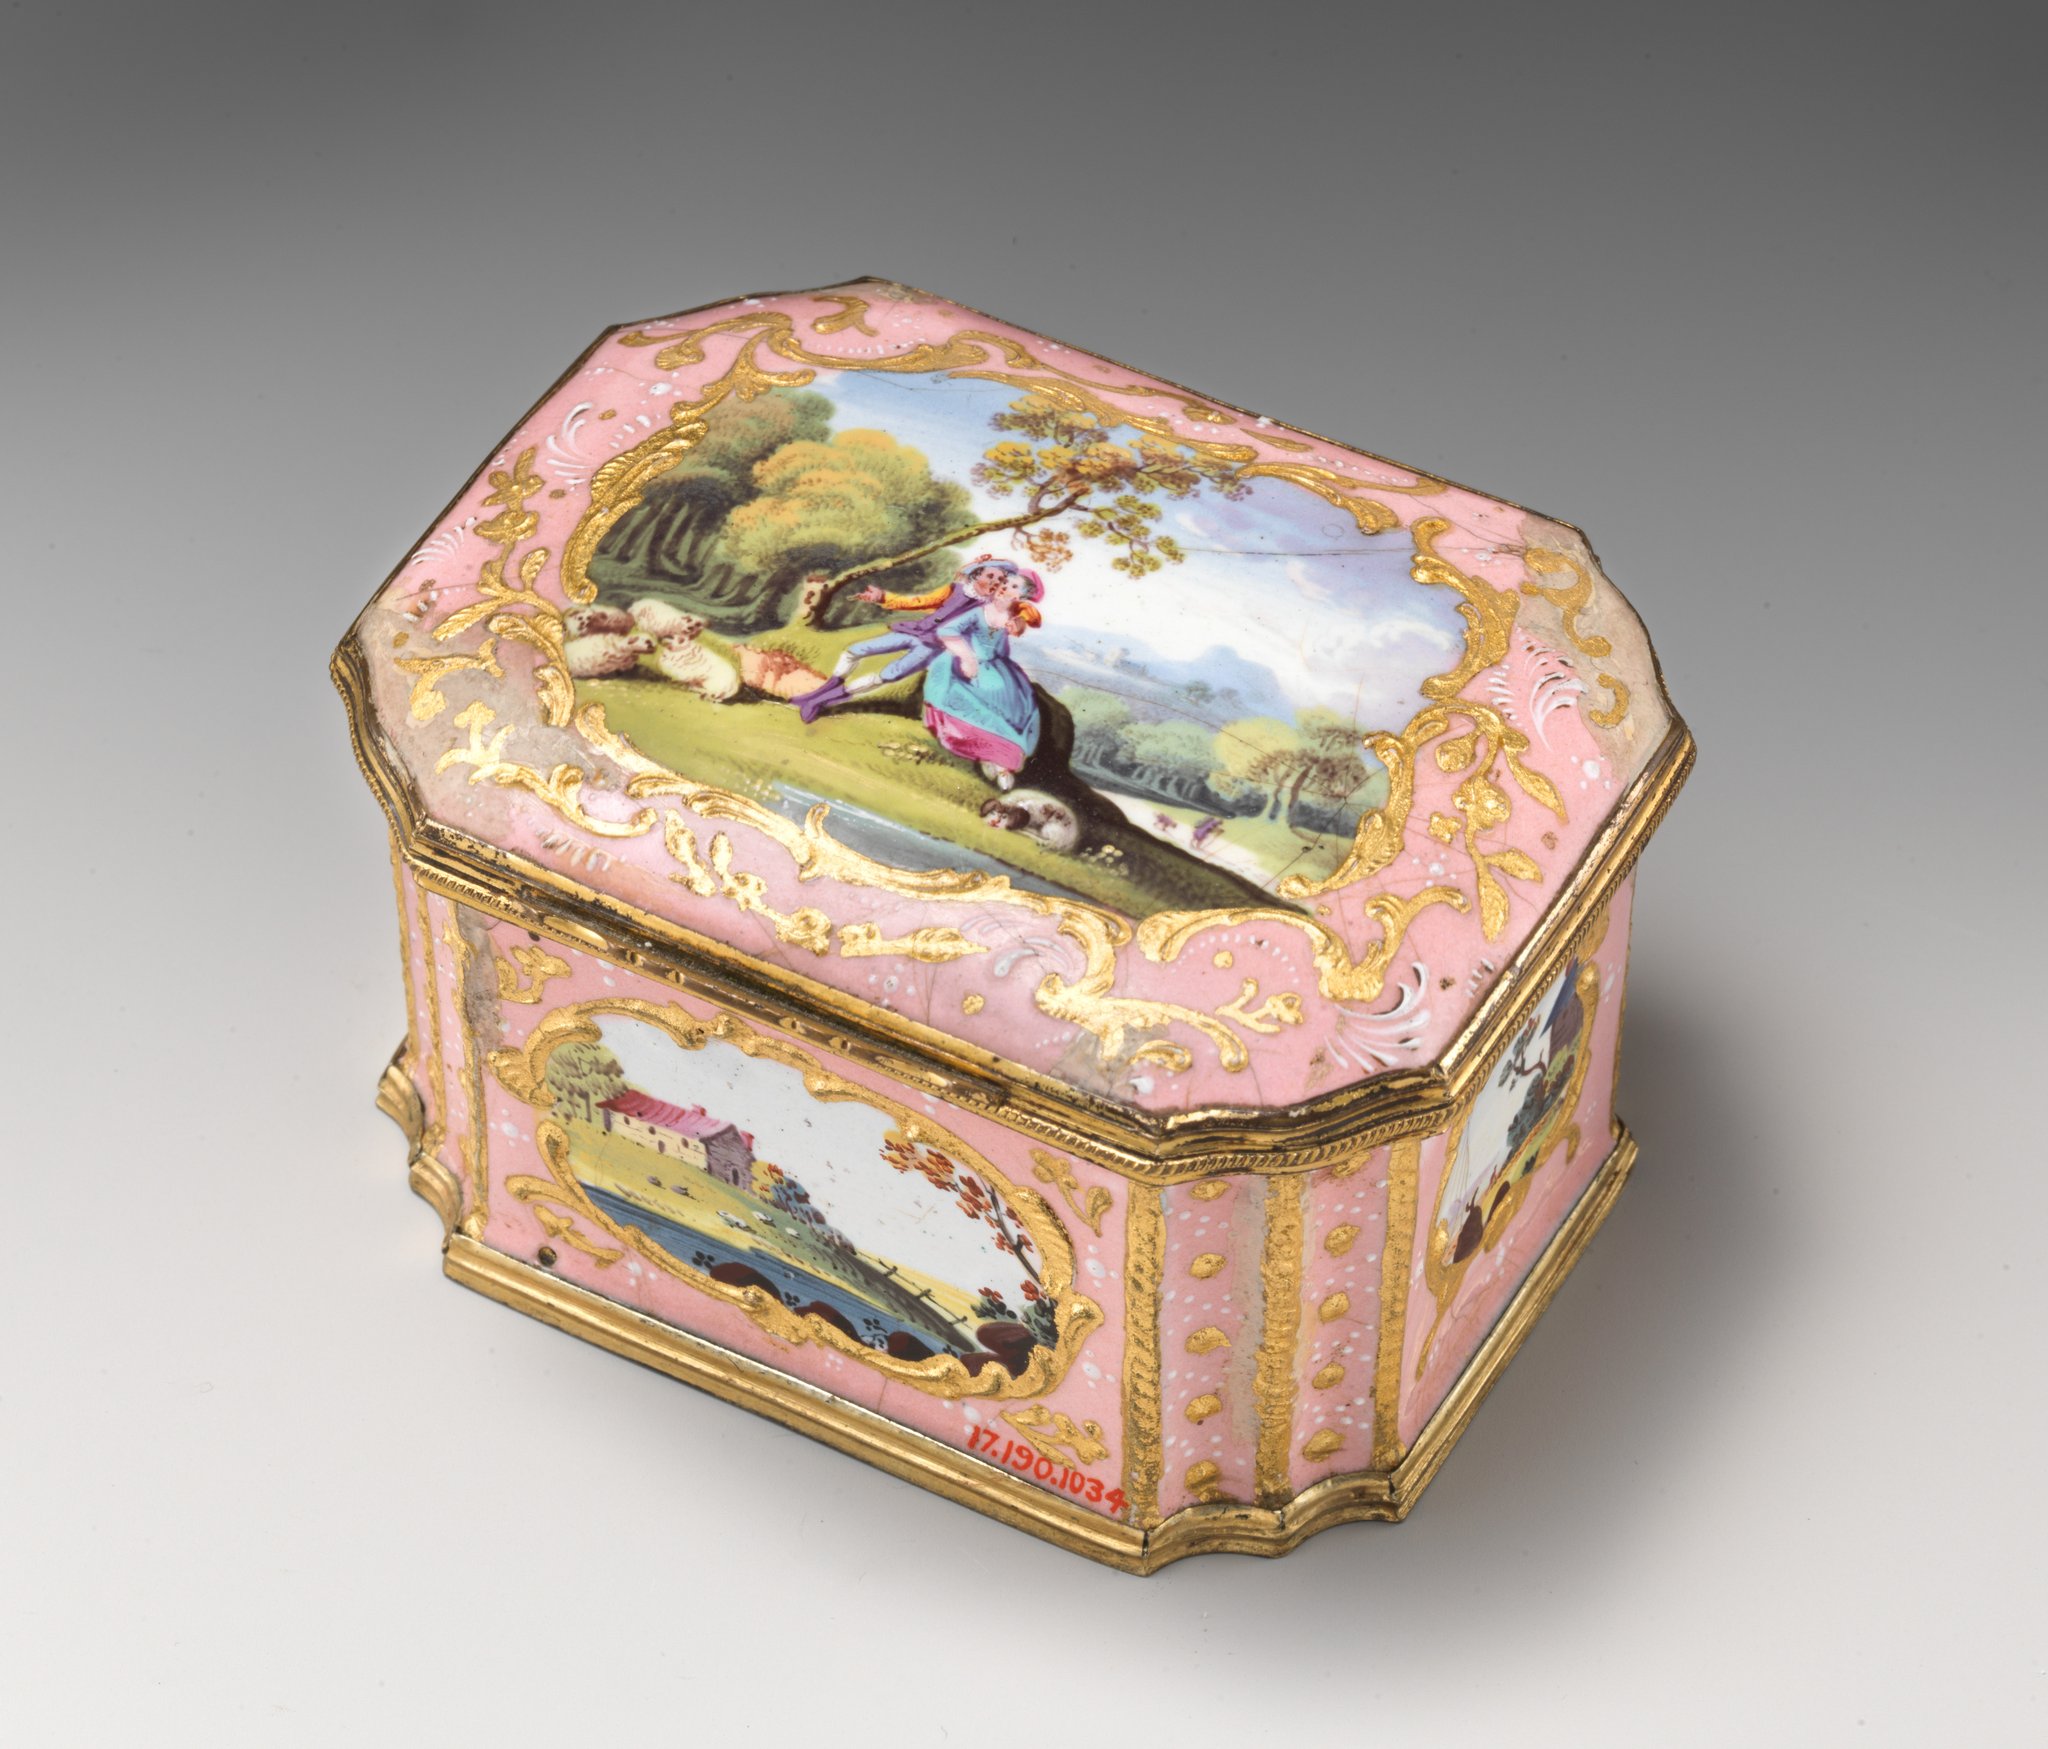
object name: snuffbox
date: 1765-1770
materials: copper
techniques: enamel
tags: houses,couples,trees